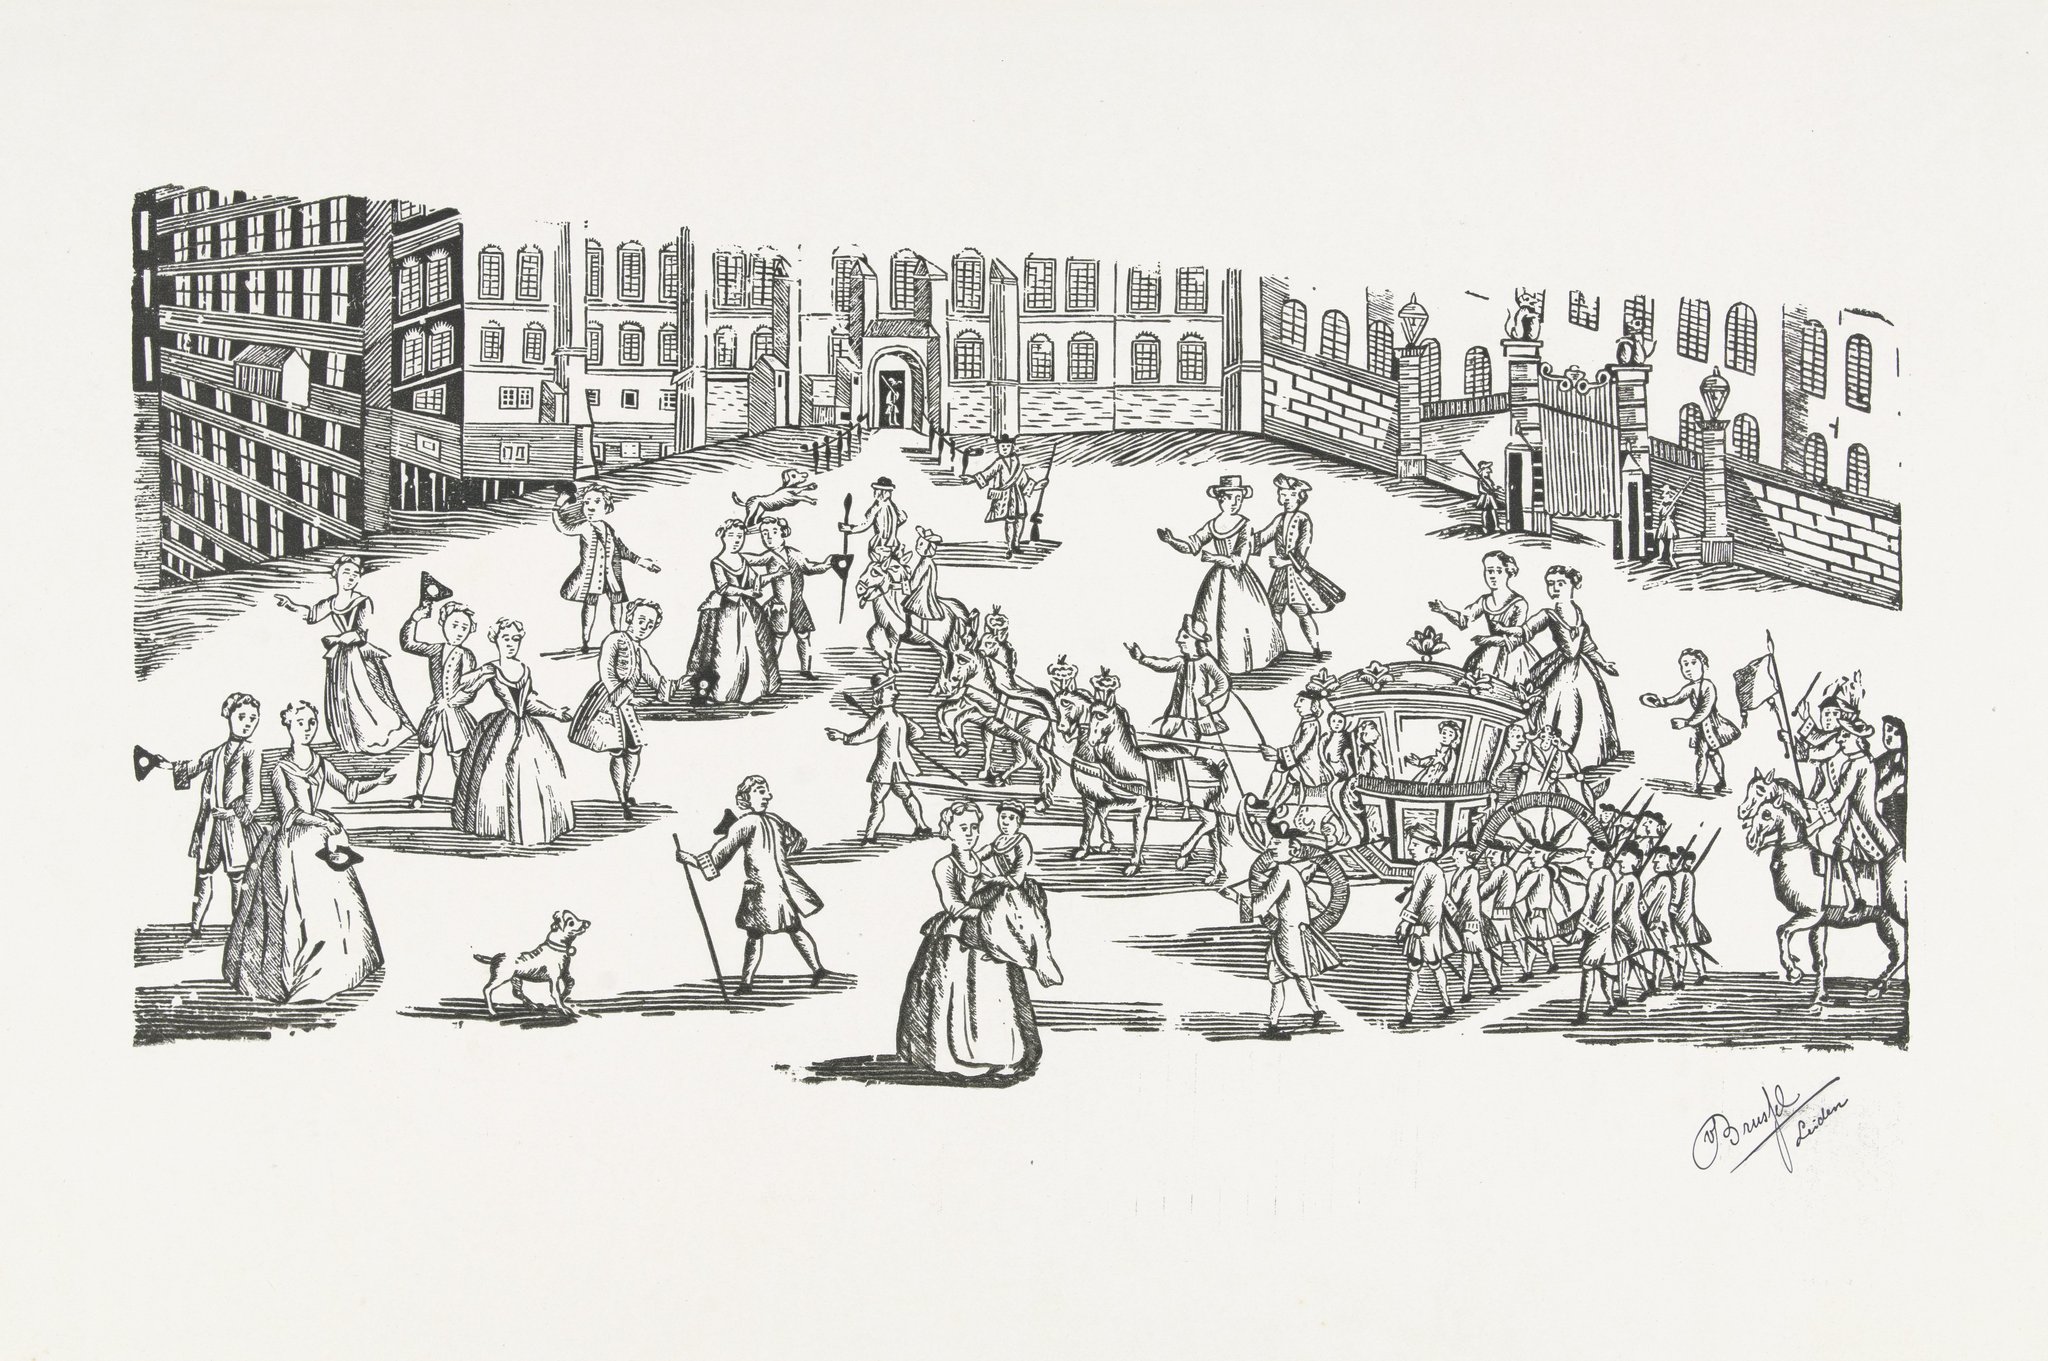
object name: popular print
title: Intrede van prins Willem V en Wilhelmina van Pruisen te Den Haag, 1767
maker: Anonymous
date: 1767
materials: paper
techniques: woodcut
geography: northern netherlands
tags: the hague, william v (prince of orange), triumphal entry and public reception, pageant, 'entrée solennelle', 'joyeuse entrée'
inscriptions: inscription: ‘v Brusssel / Leiden’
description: Intrede van een vorst in een koets in een stad, waarschijnlijk de aankomst prins Willem V en Wilhelmina van Pruisen bij Paleis Noordeinde te Den Haag, november 1767.